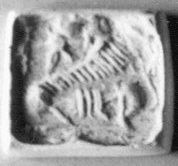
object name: stamp seal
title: Stamp seal (tabloid) with monster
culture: assyrian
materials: stone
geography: syria